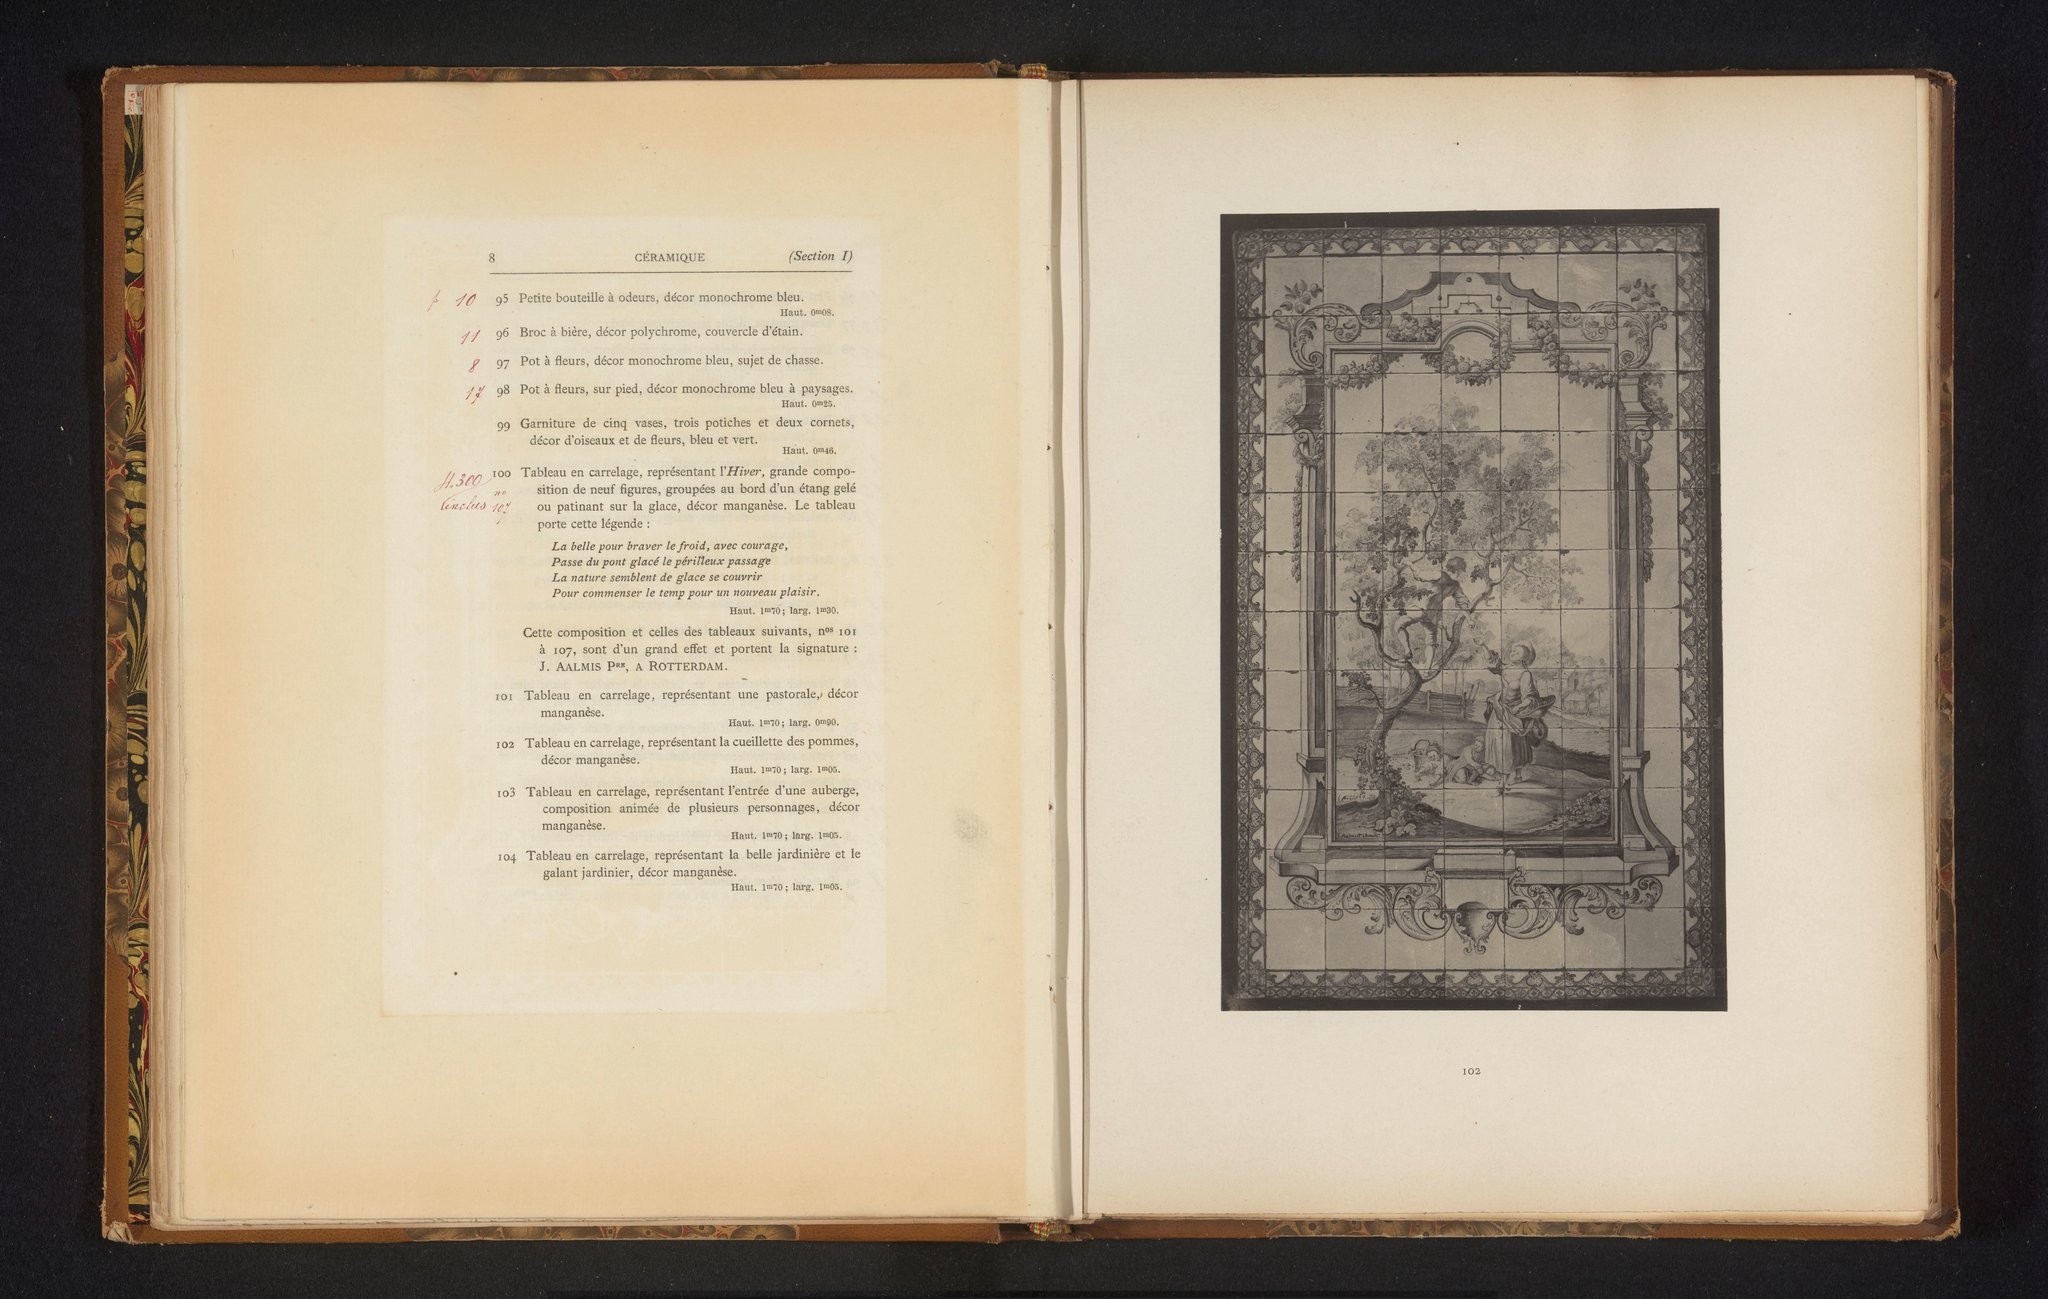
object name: page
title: Tegelwand van het plukken van appels in het huis van Antonin Terme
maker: Anonymous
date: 1880-1885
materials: photographic support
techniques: platinum process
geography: liège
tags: art collection, art gallery, interior of the house, tiles, bricks ~ building material